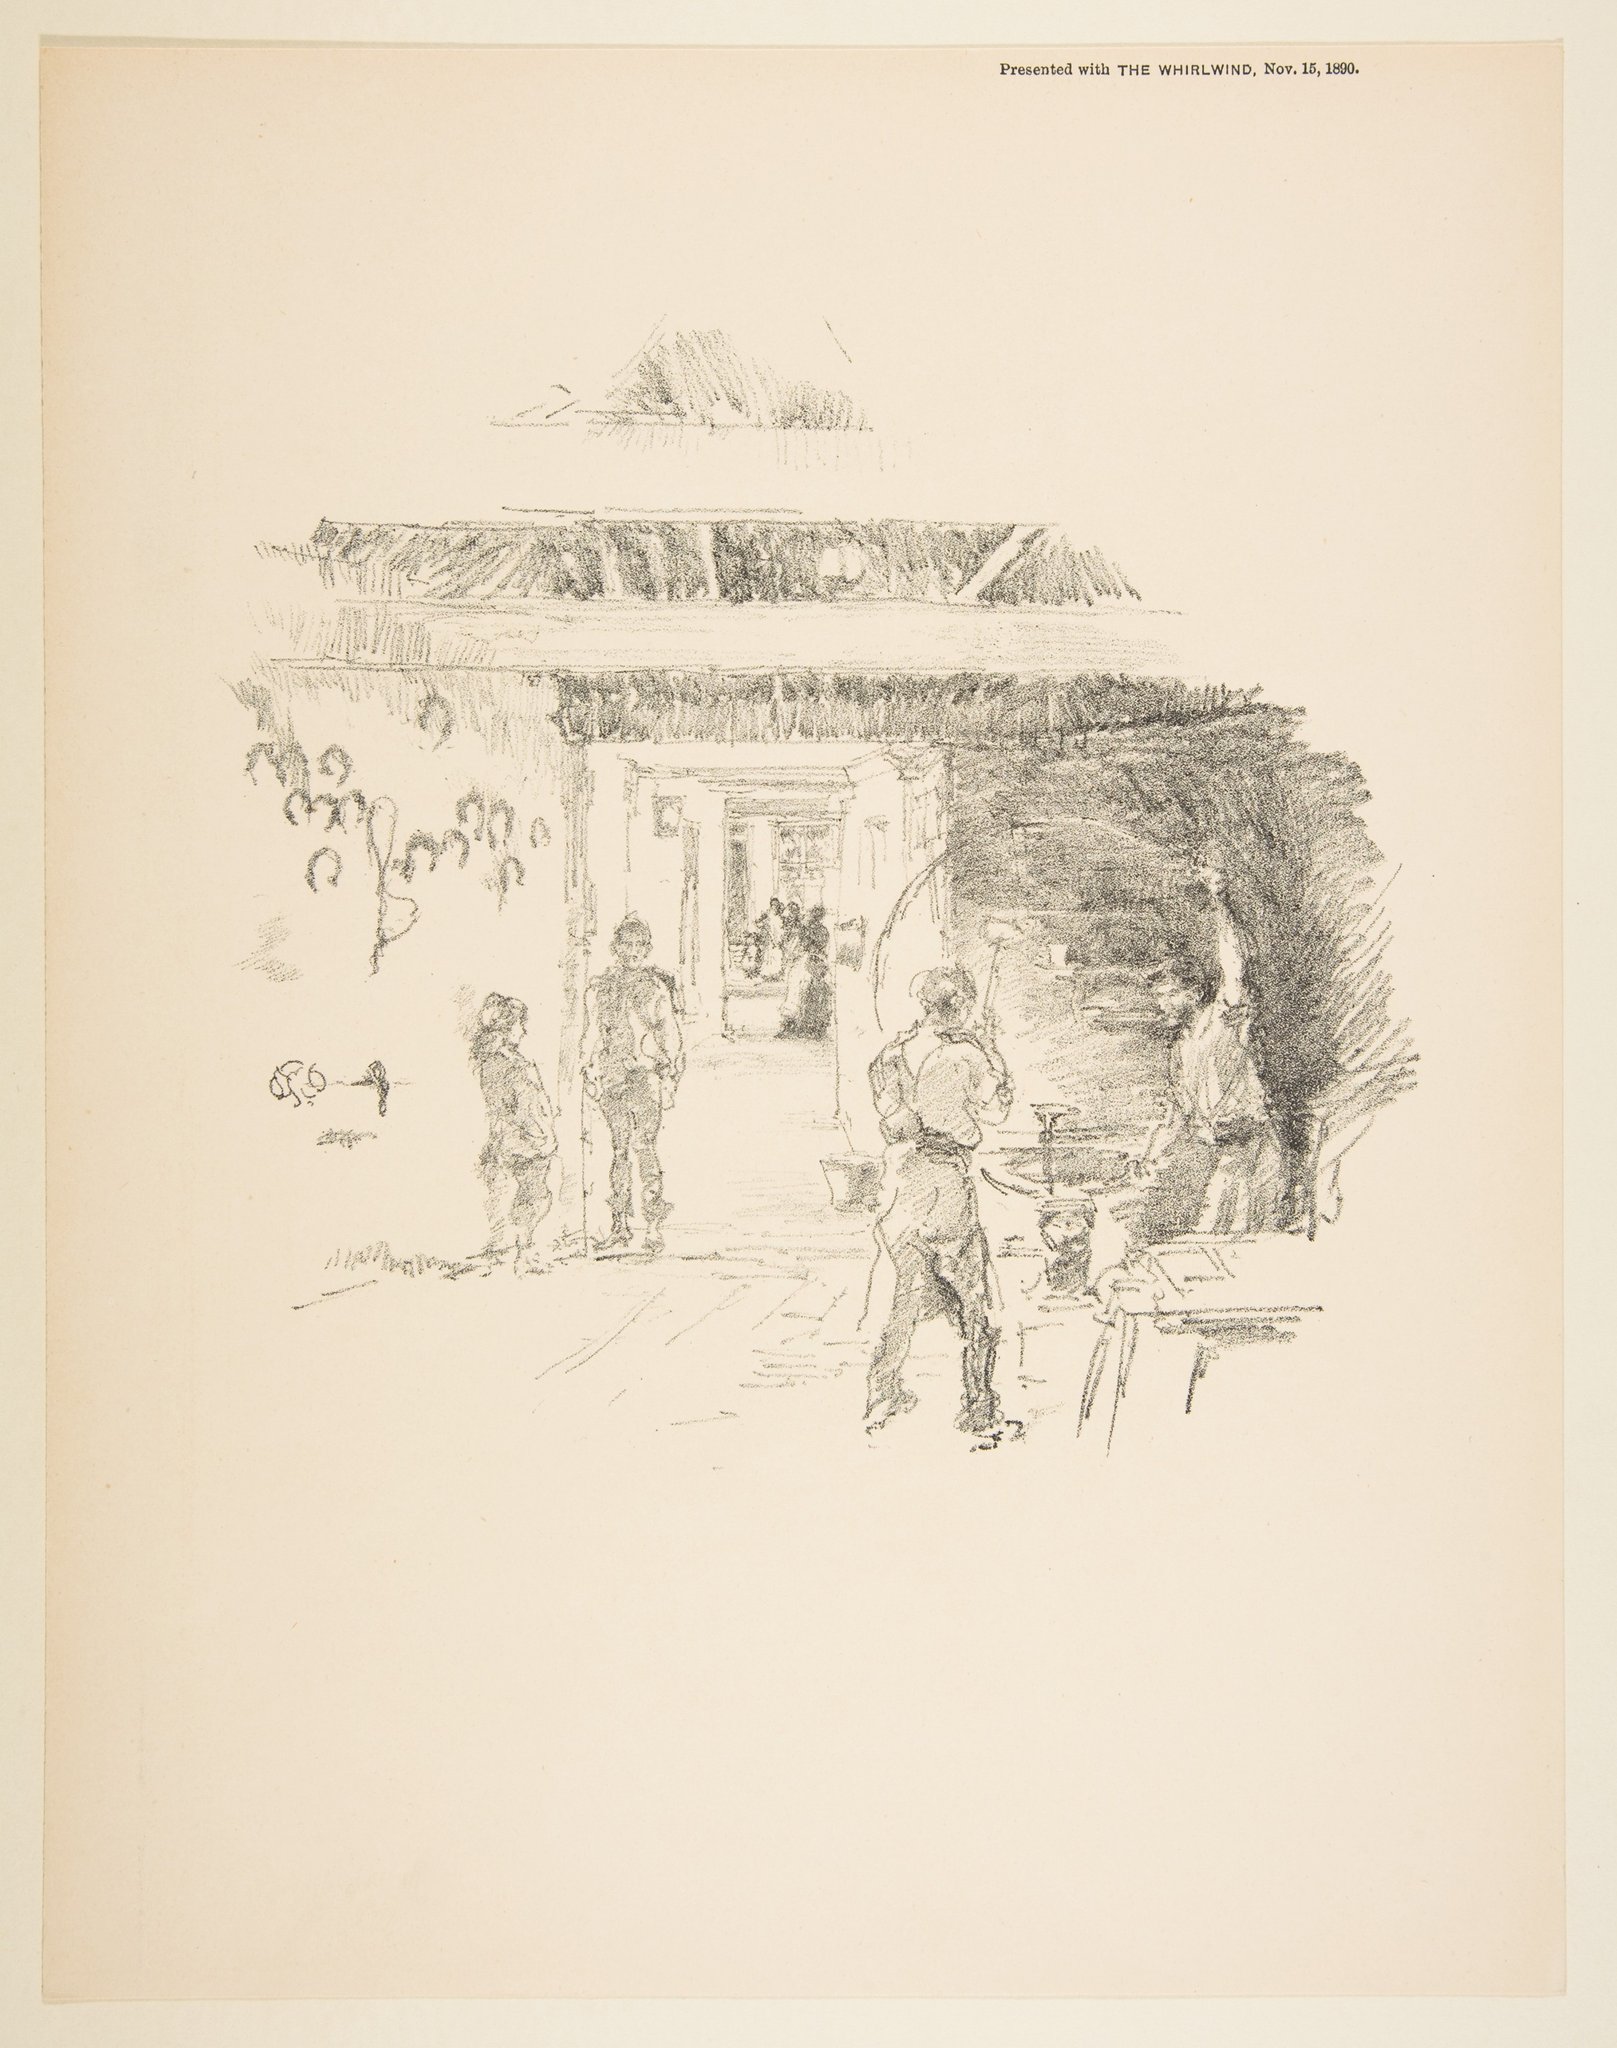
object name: print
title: The Tyresmith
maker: james mcneill whistler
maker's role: artist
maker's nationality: american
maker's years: 1834-1903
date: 1890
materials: ink, paper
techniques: printing, lithography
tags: doorways,men